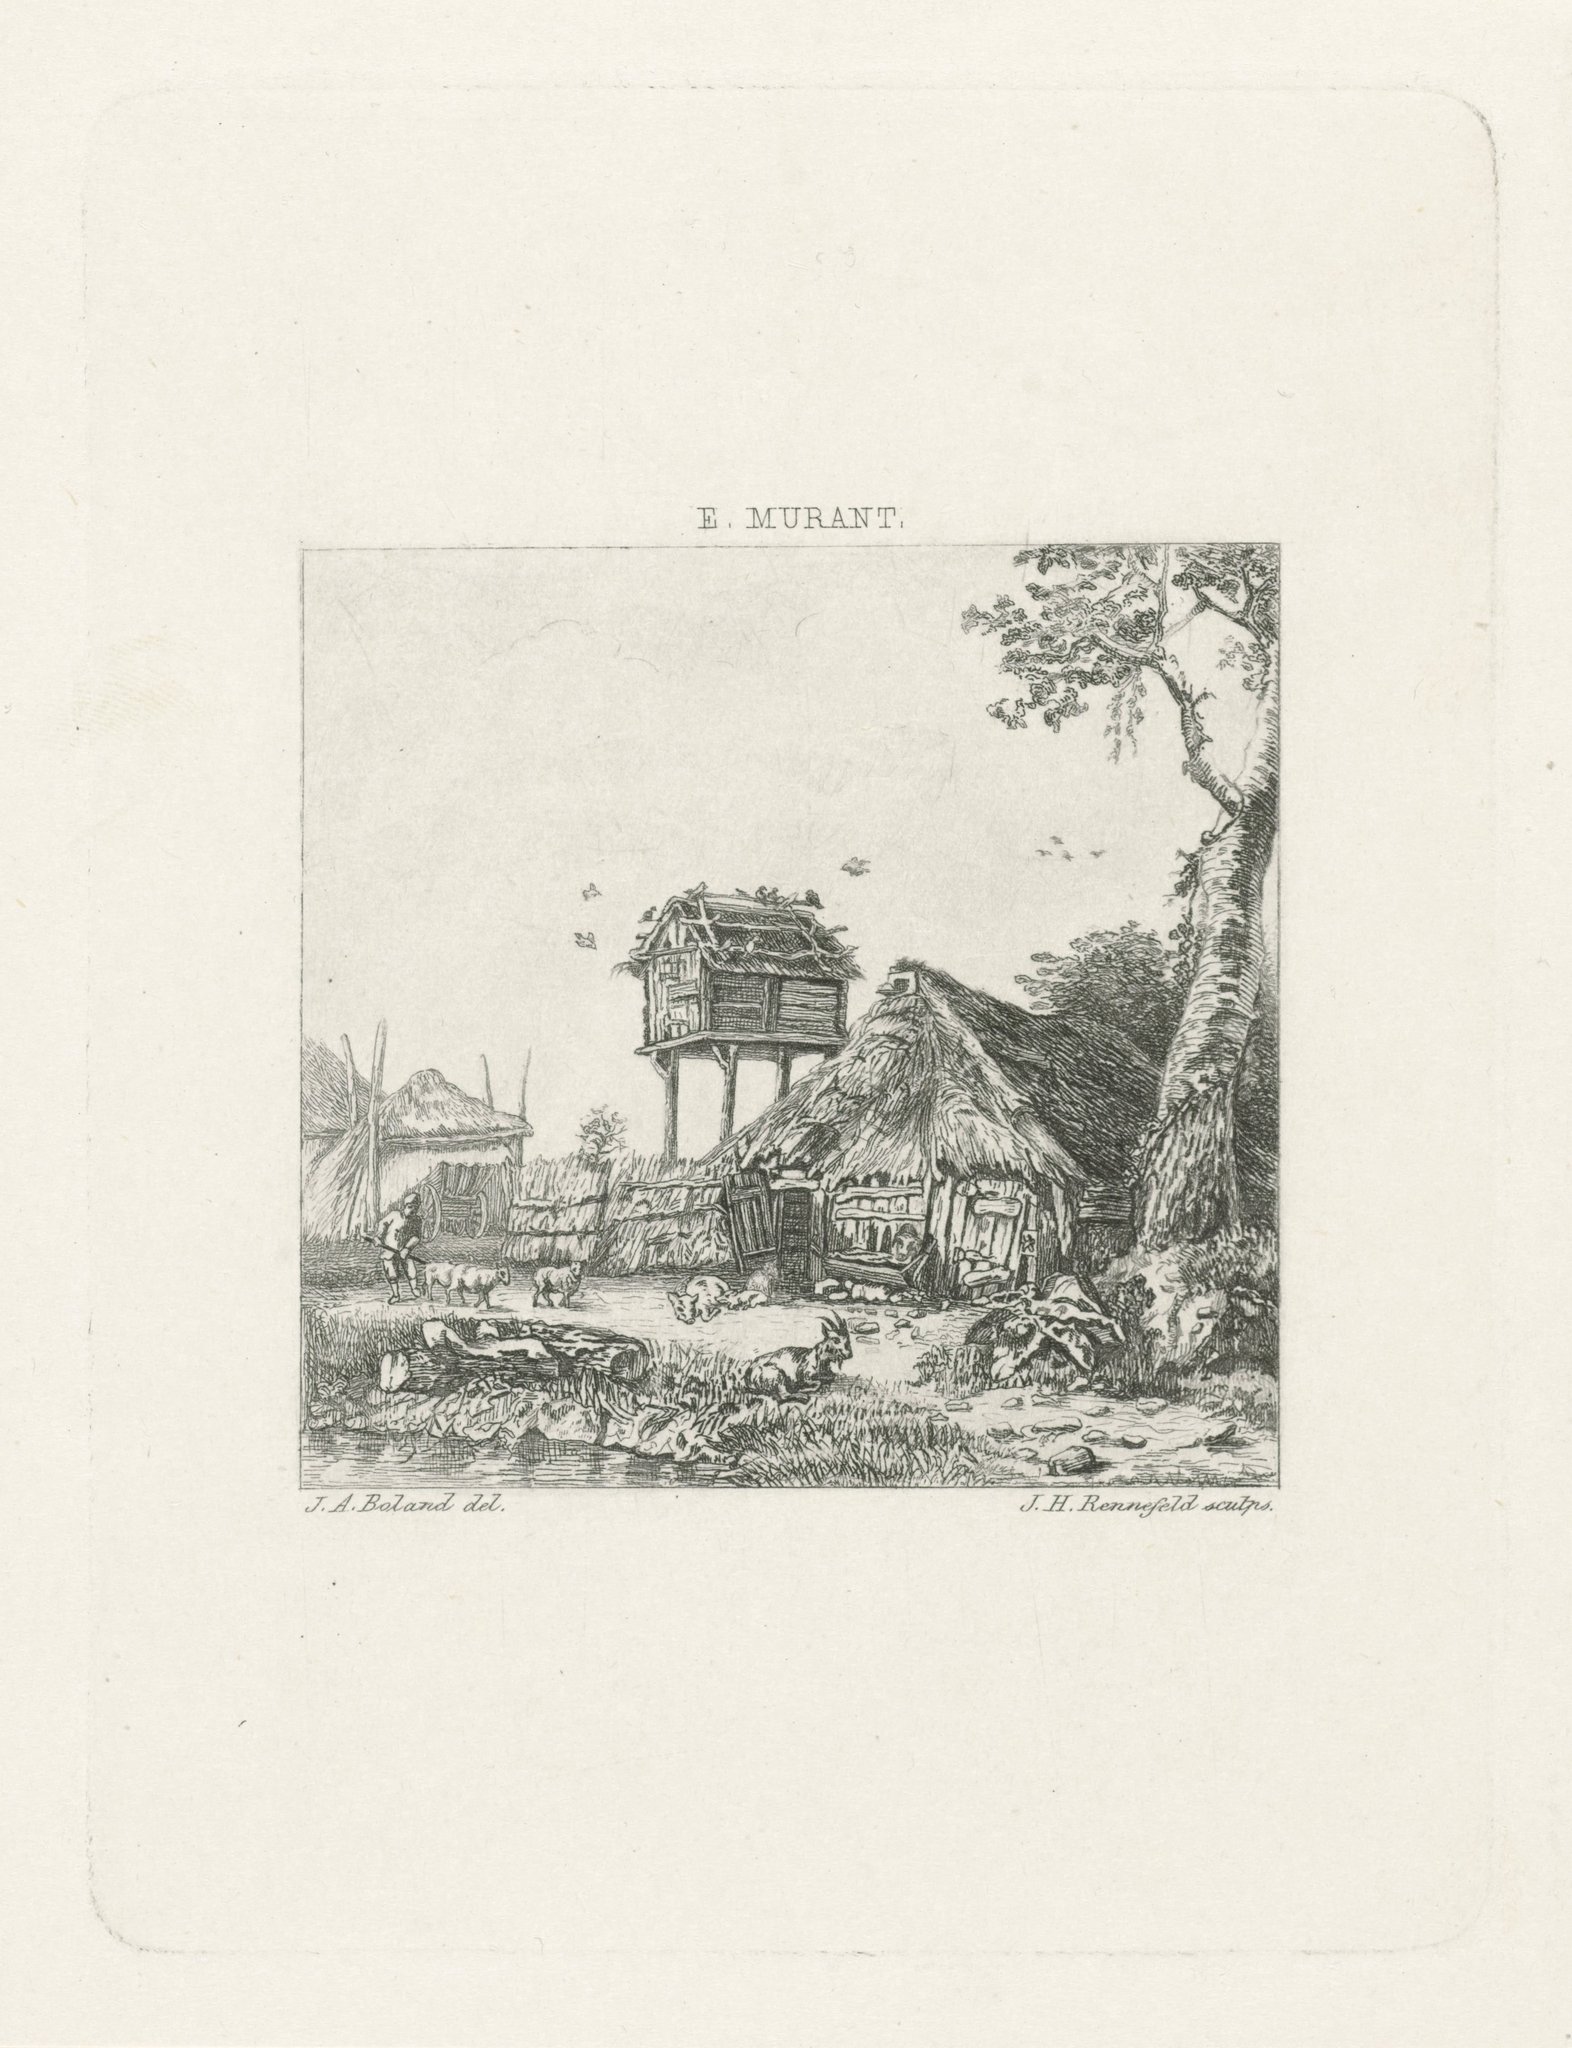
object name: print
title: Boerenerf met duiventil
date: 1845-1877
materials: paper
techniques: etching, roulette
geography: amsterdam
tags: cow, farmers, dove-cote, goat, farm (building)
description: Gezicht op een boerenerf met een vervallen boerderij en een duiventil. Op het erf een boer en vee.